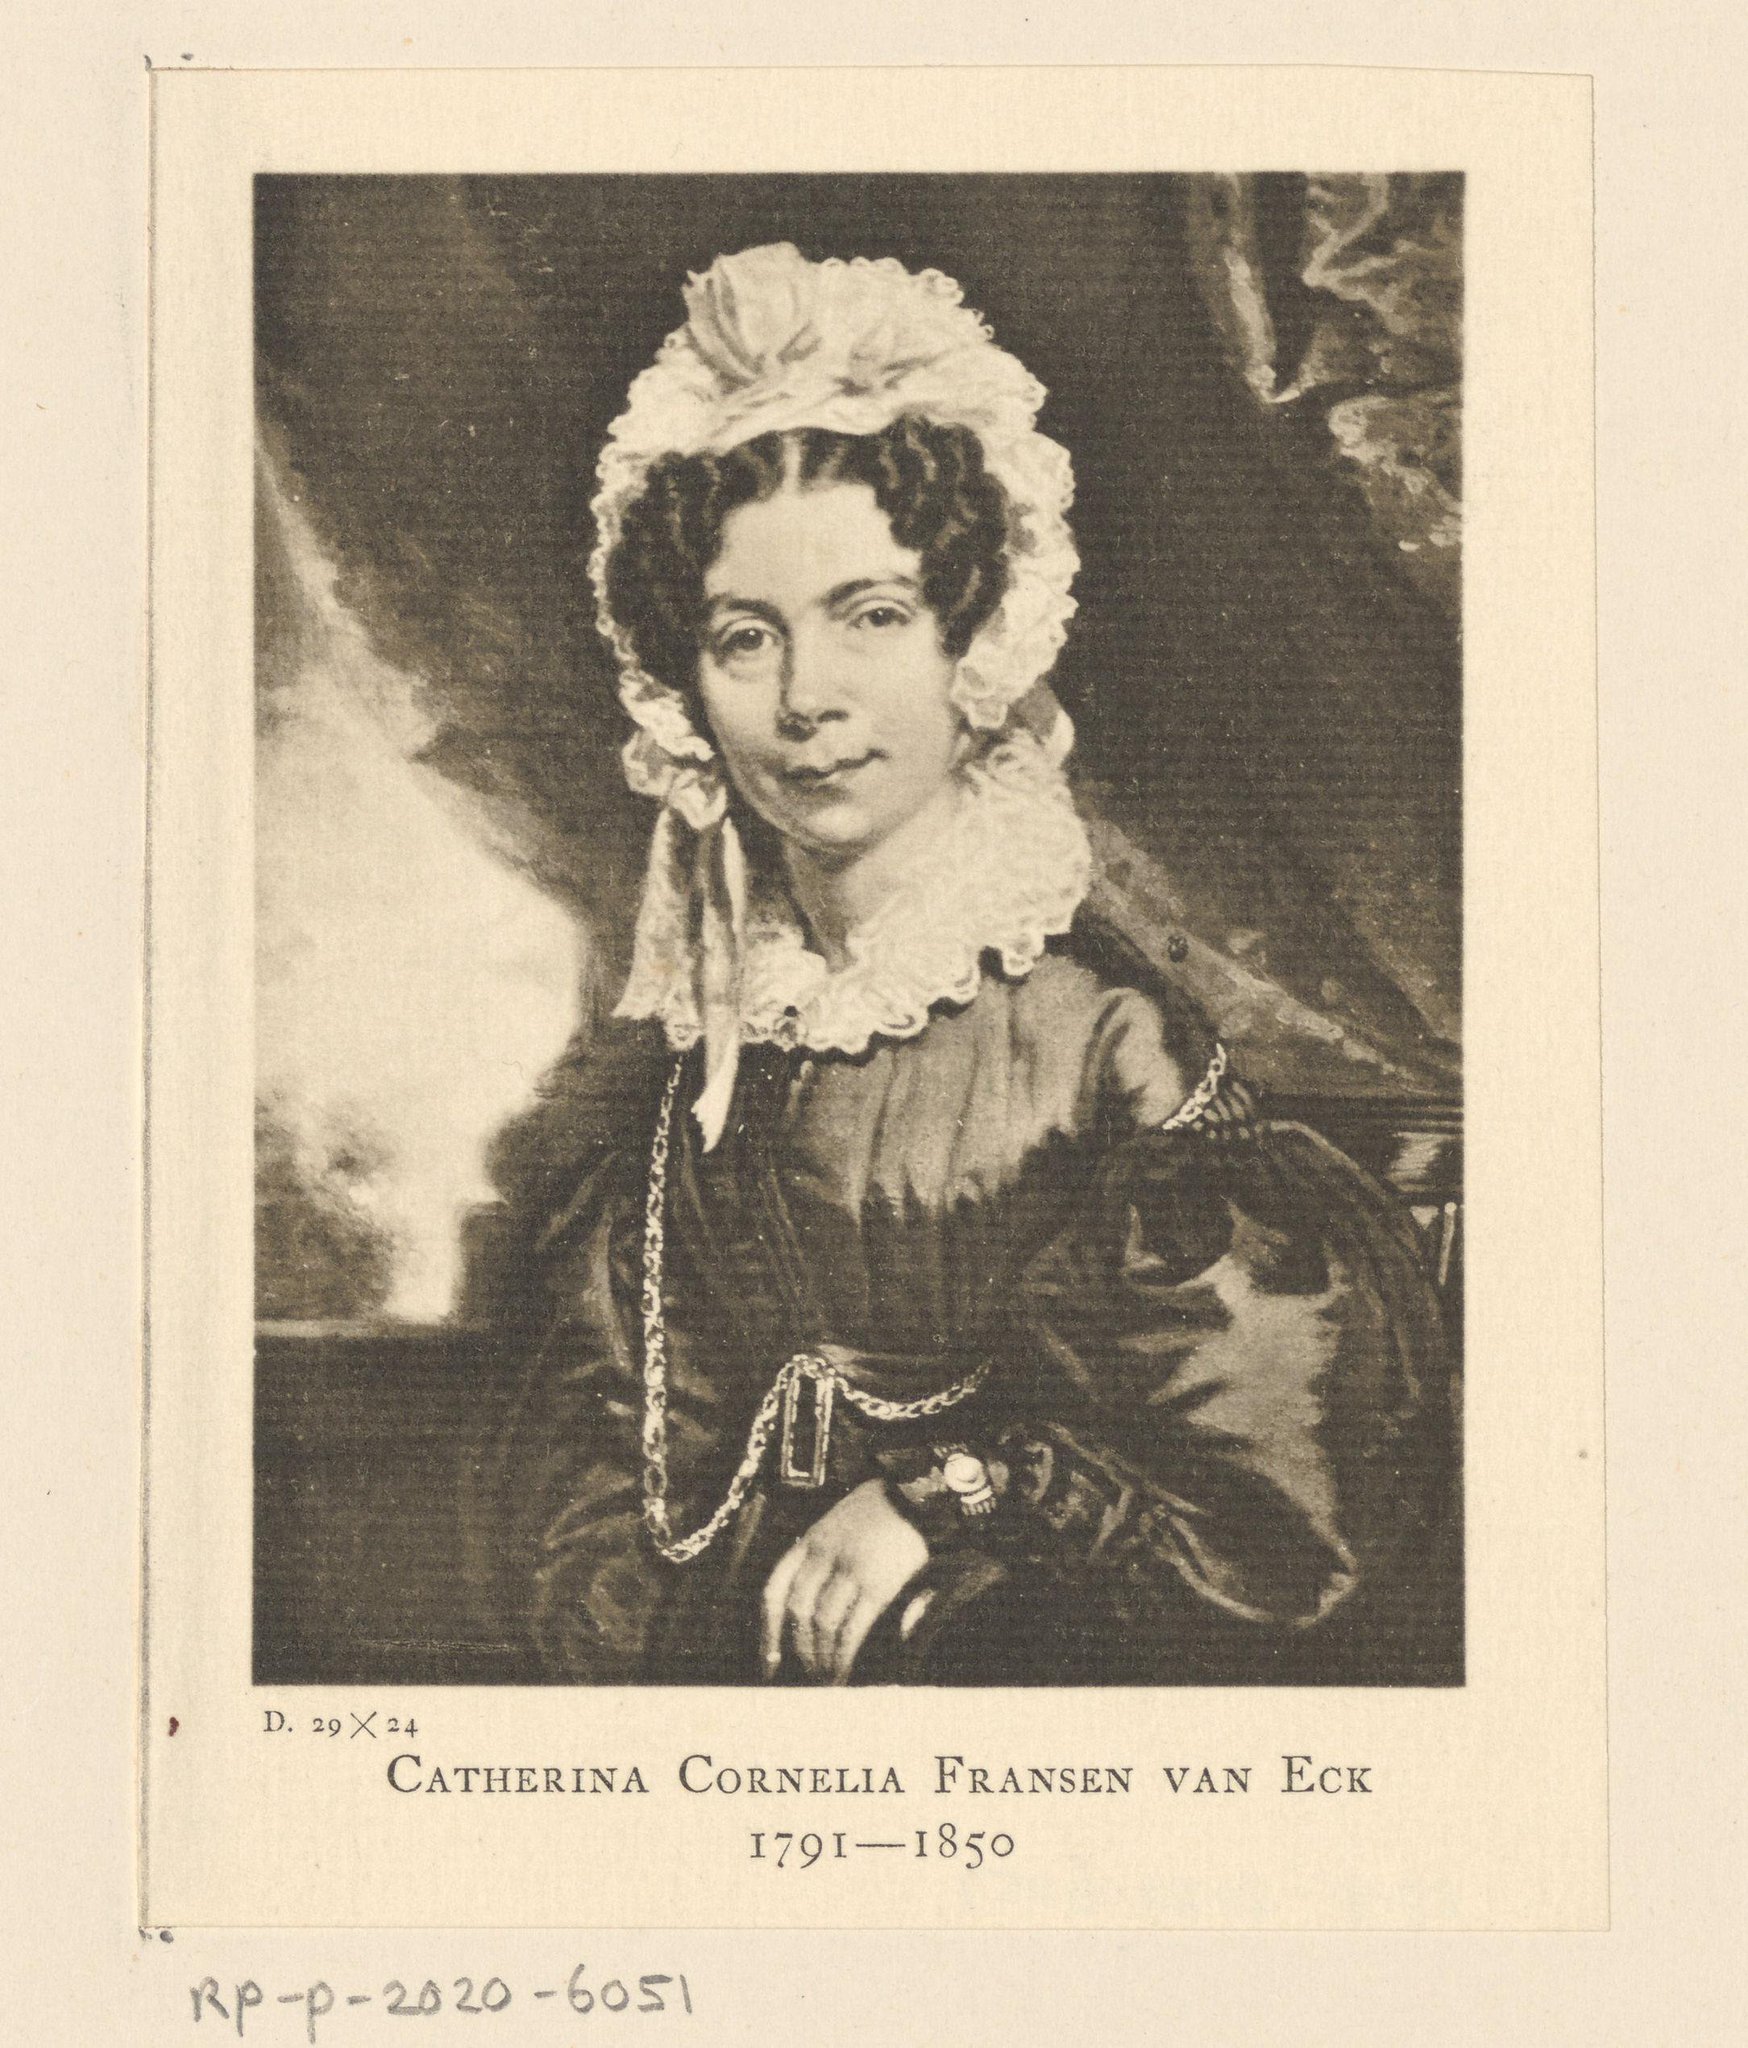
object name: photomechanical print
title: Portret van Catherina Cornelia Fransen van Eck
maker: Anonymous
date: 1875-1930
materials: paper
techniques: photograph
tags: deventer, historical persons - bb - woman